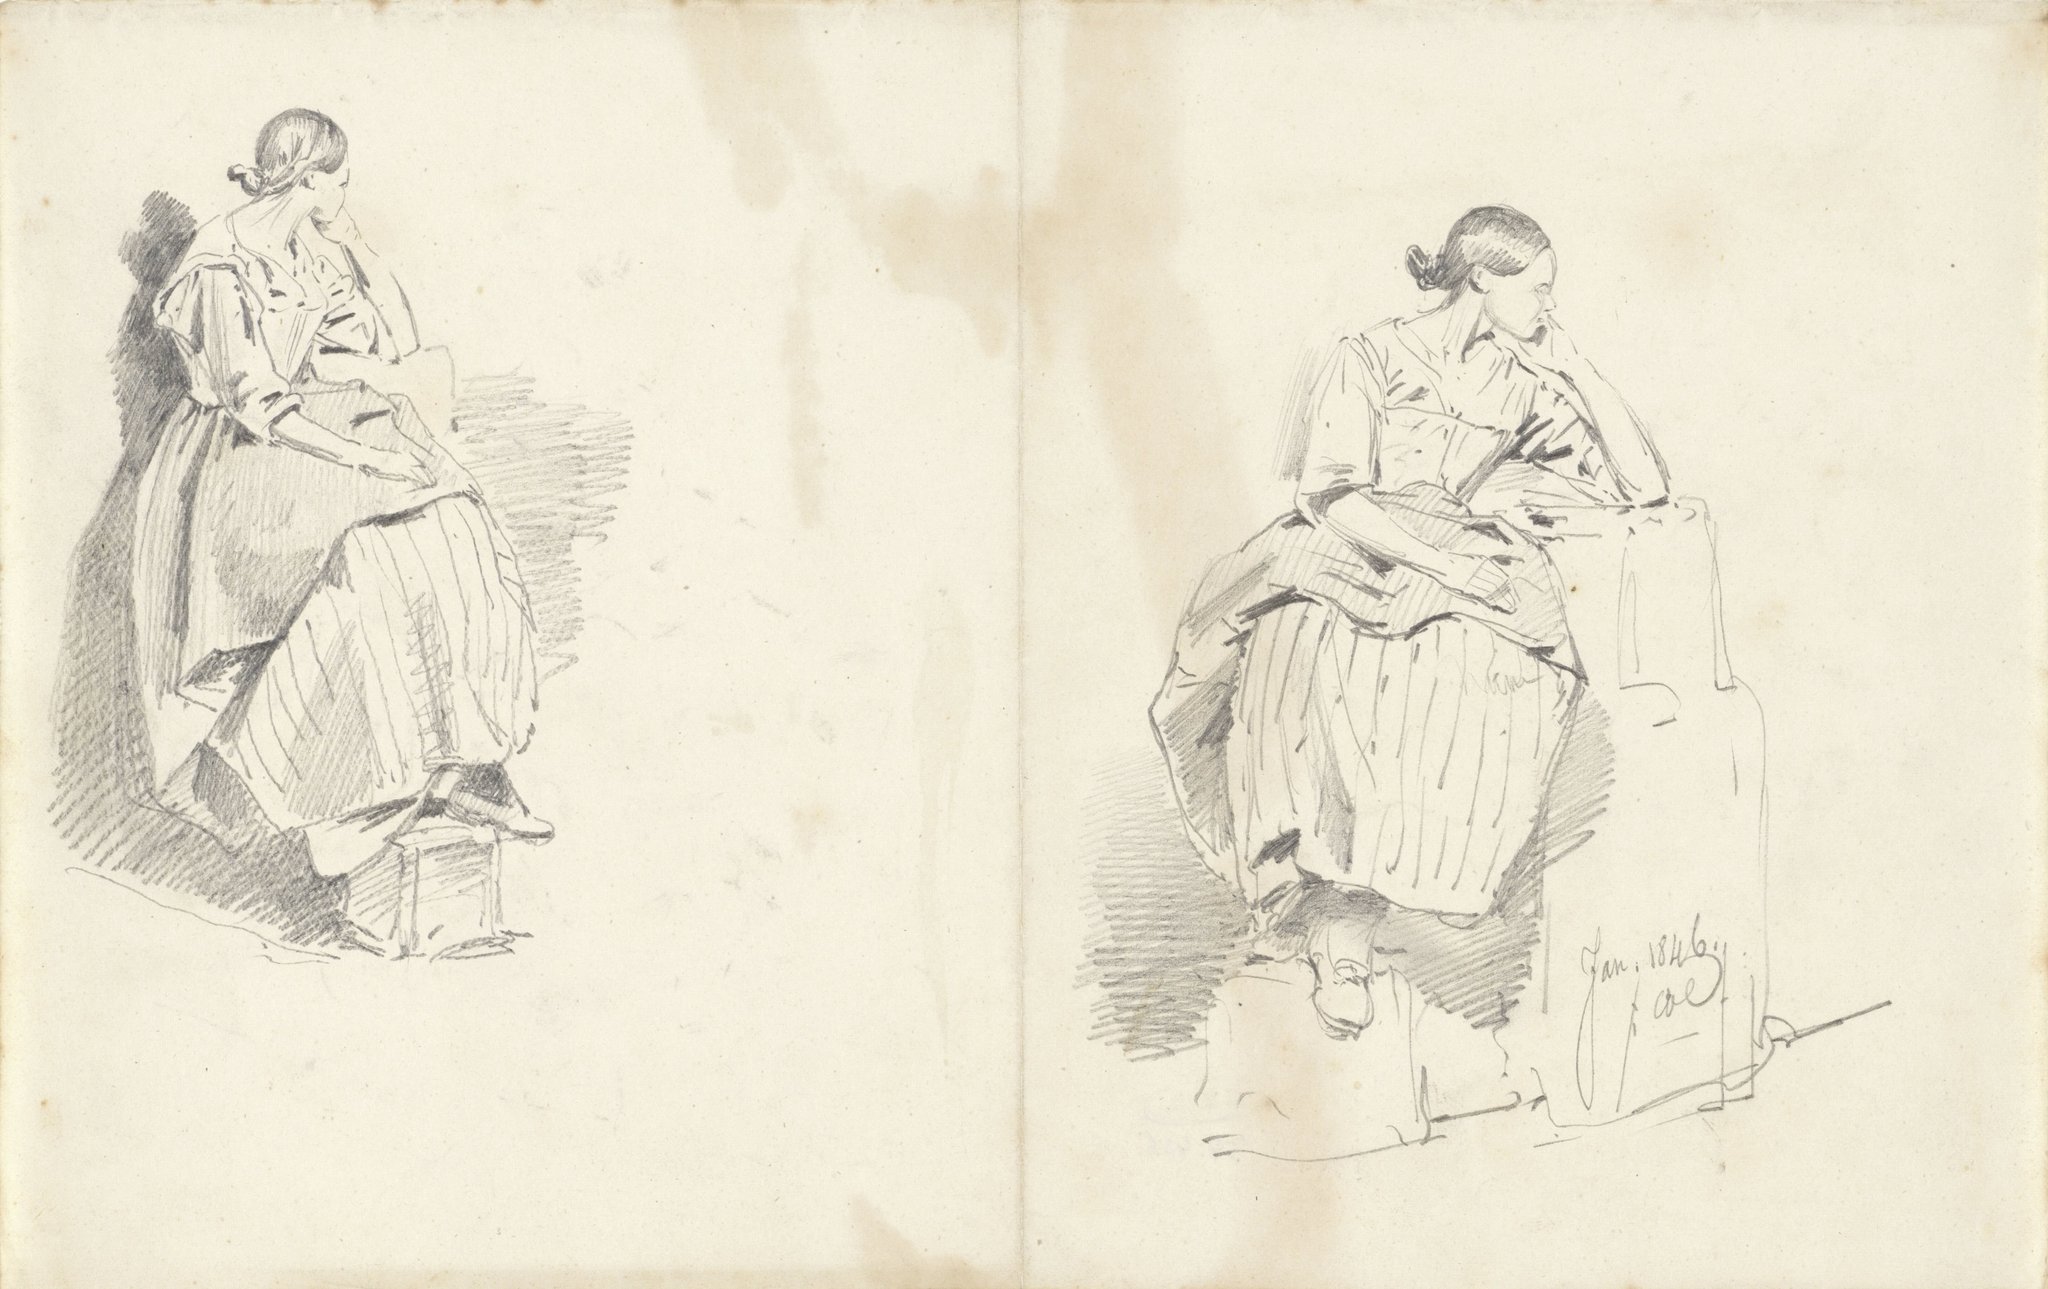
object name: drawing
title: Twee studies van een zittende vrouw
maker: pieter van loon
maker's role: draughtsman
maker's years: 1801-1873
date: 1801-1846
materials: paper, pencil